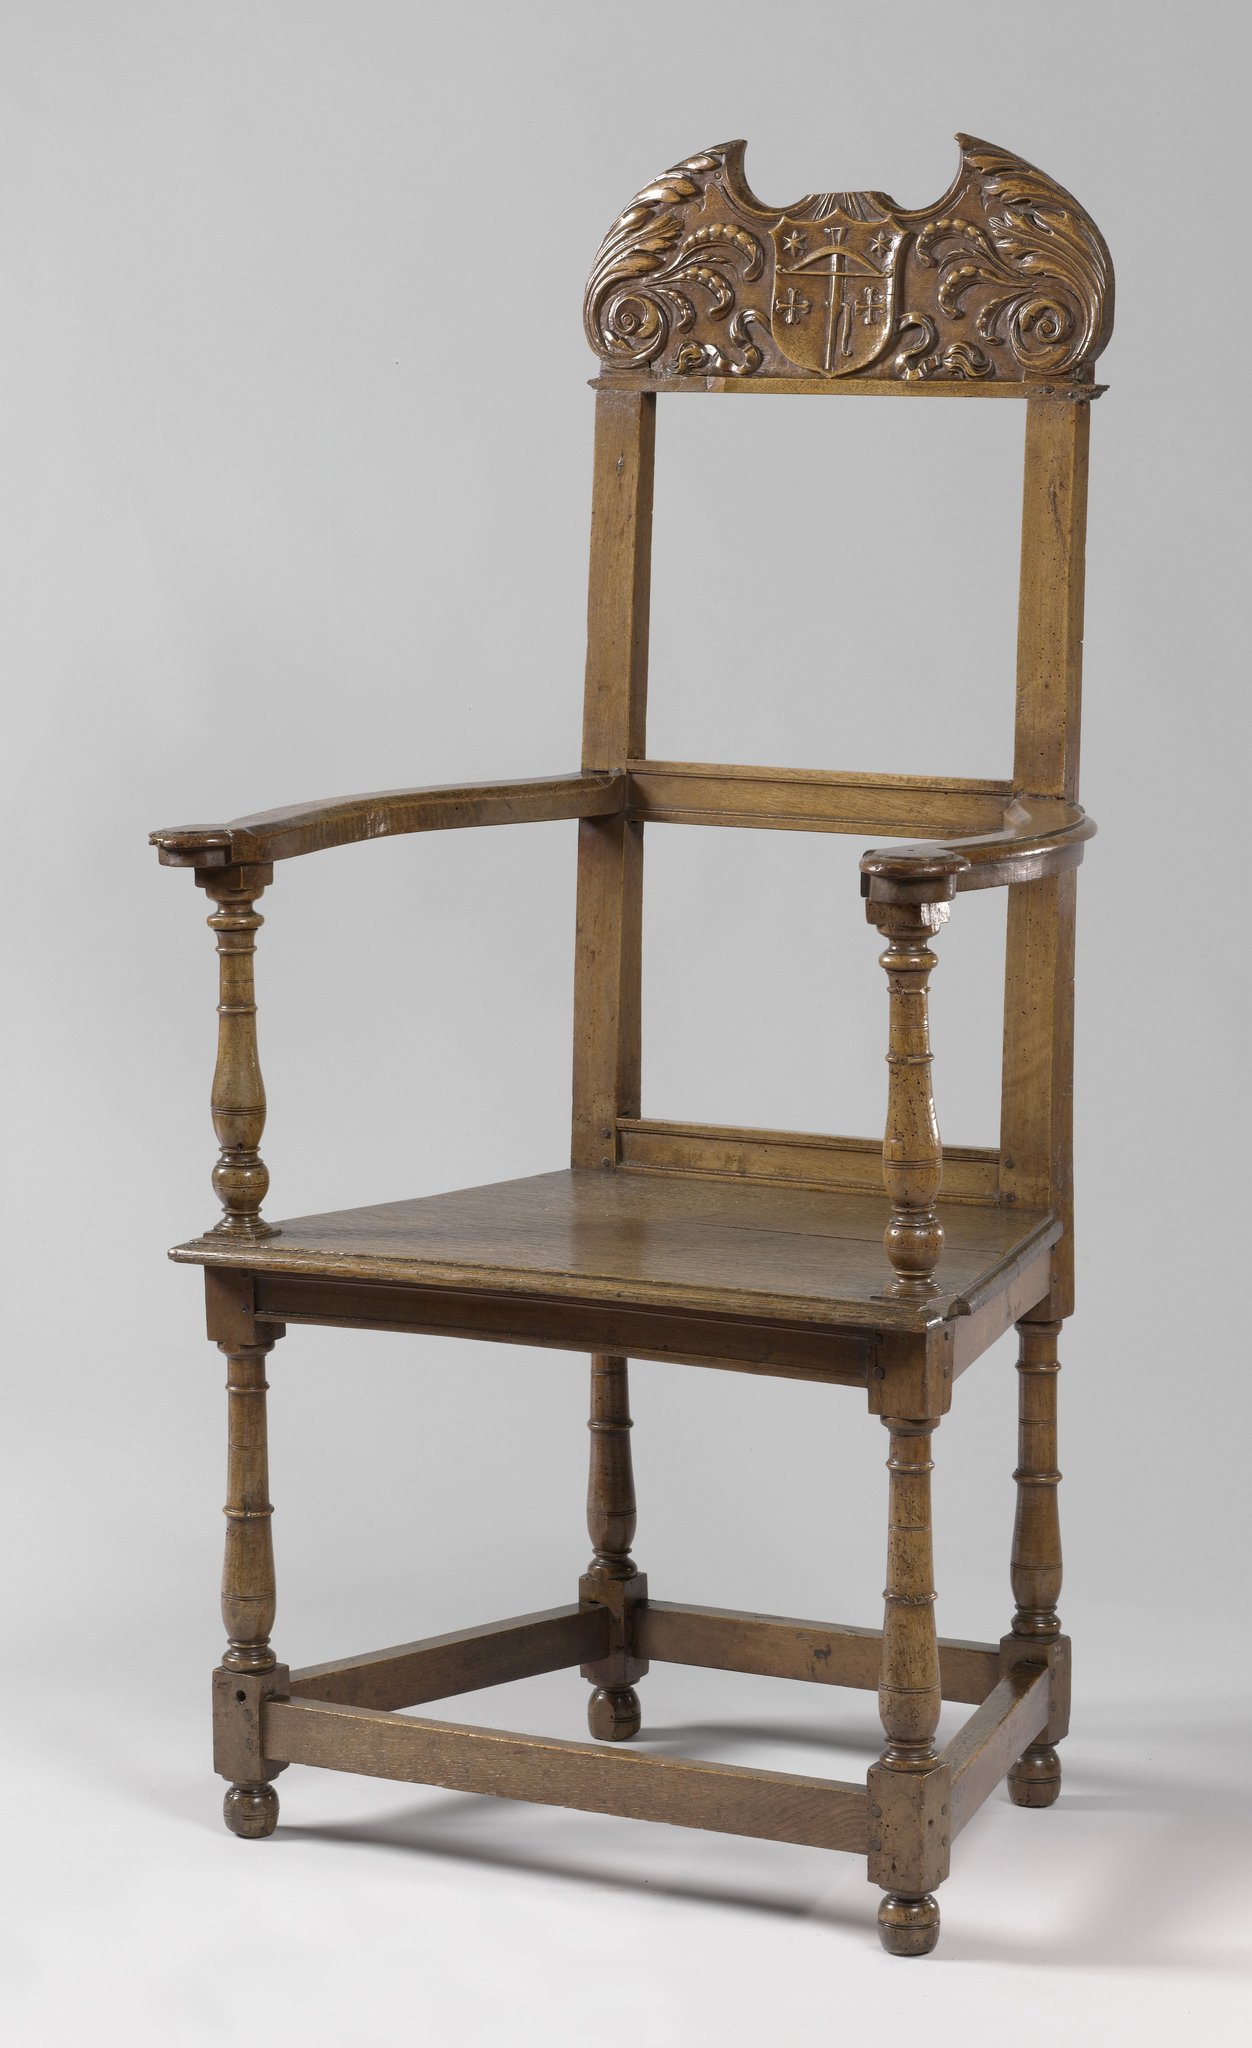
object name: furniture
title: Armchair of a guild of Saint George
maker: Anonymous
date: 1550-1599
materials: wood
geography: northern netherlands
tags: acanthus ~ ornament, archer's weapons: crossbow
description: The flourishing of civic militia companies testifies to the growing power of ordinary citizens. Each guild had its own building, the doelen. This chair stood in the doelen of a guild of crossbowmen, as can be seen from the crossbow depicted on its back. From which town it came is unknown. The patron saint of crossbowmen was Saint George.